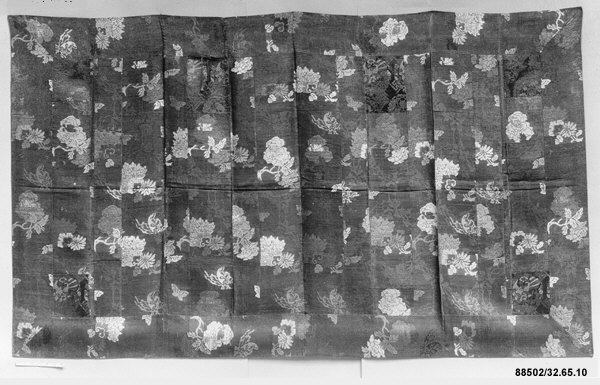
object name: robe, priest's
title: Priest's Robe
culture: japanese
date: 1701-1900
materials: metal thread, silk